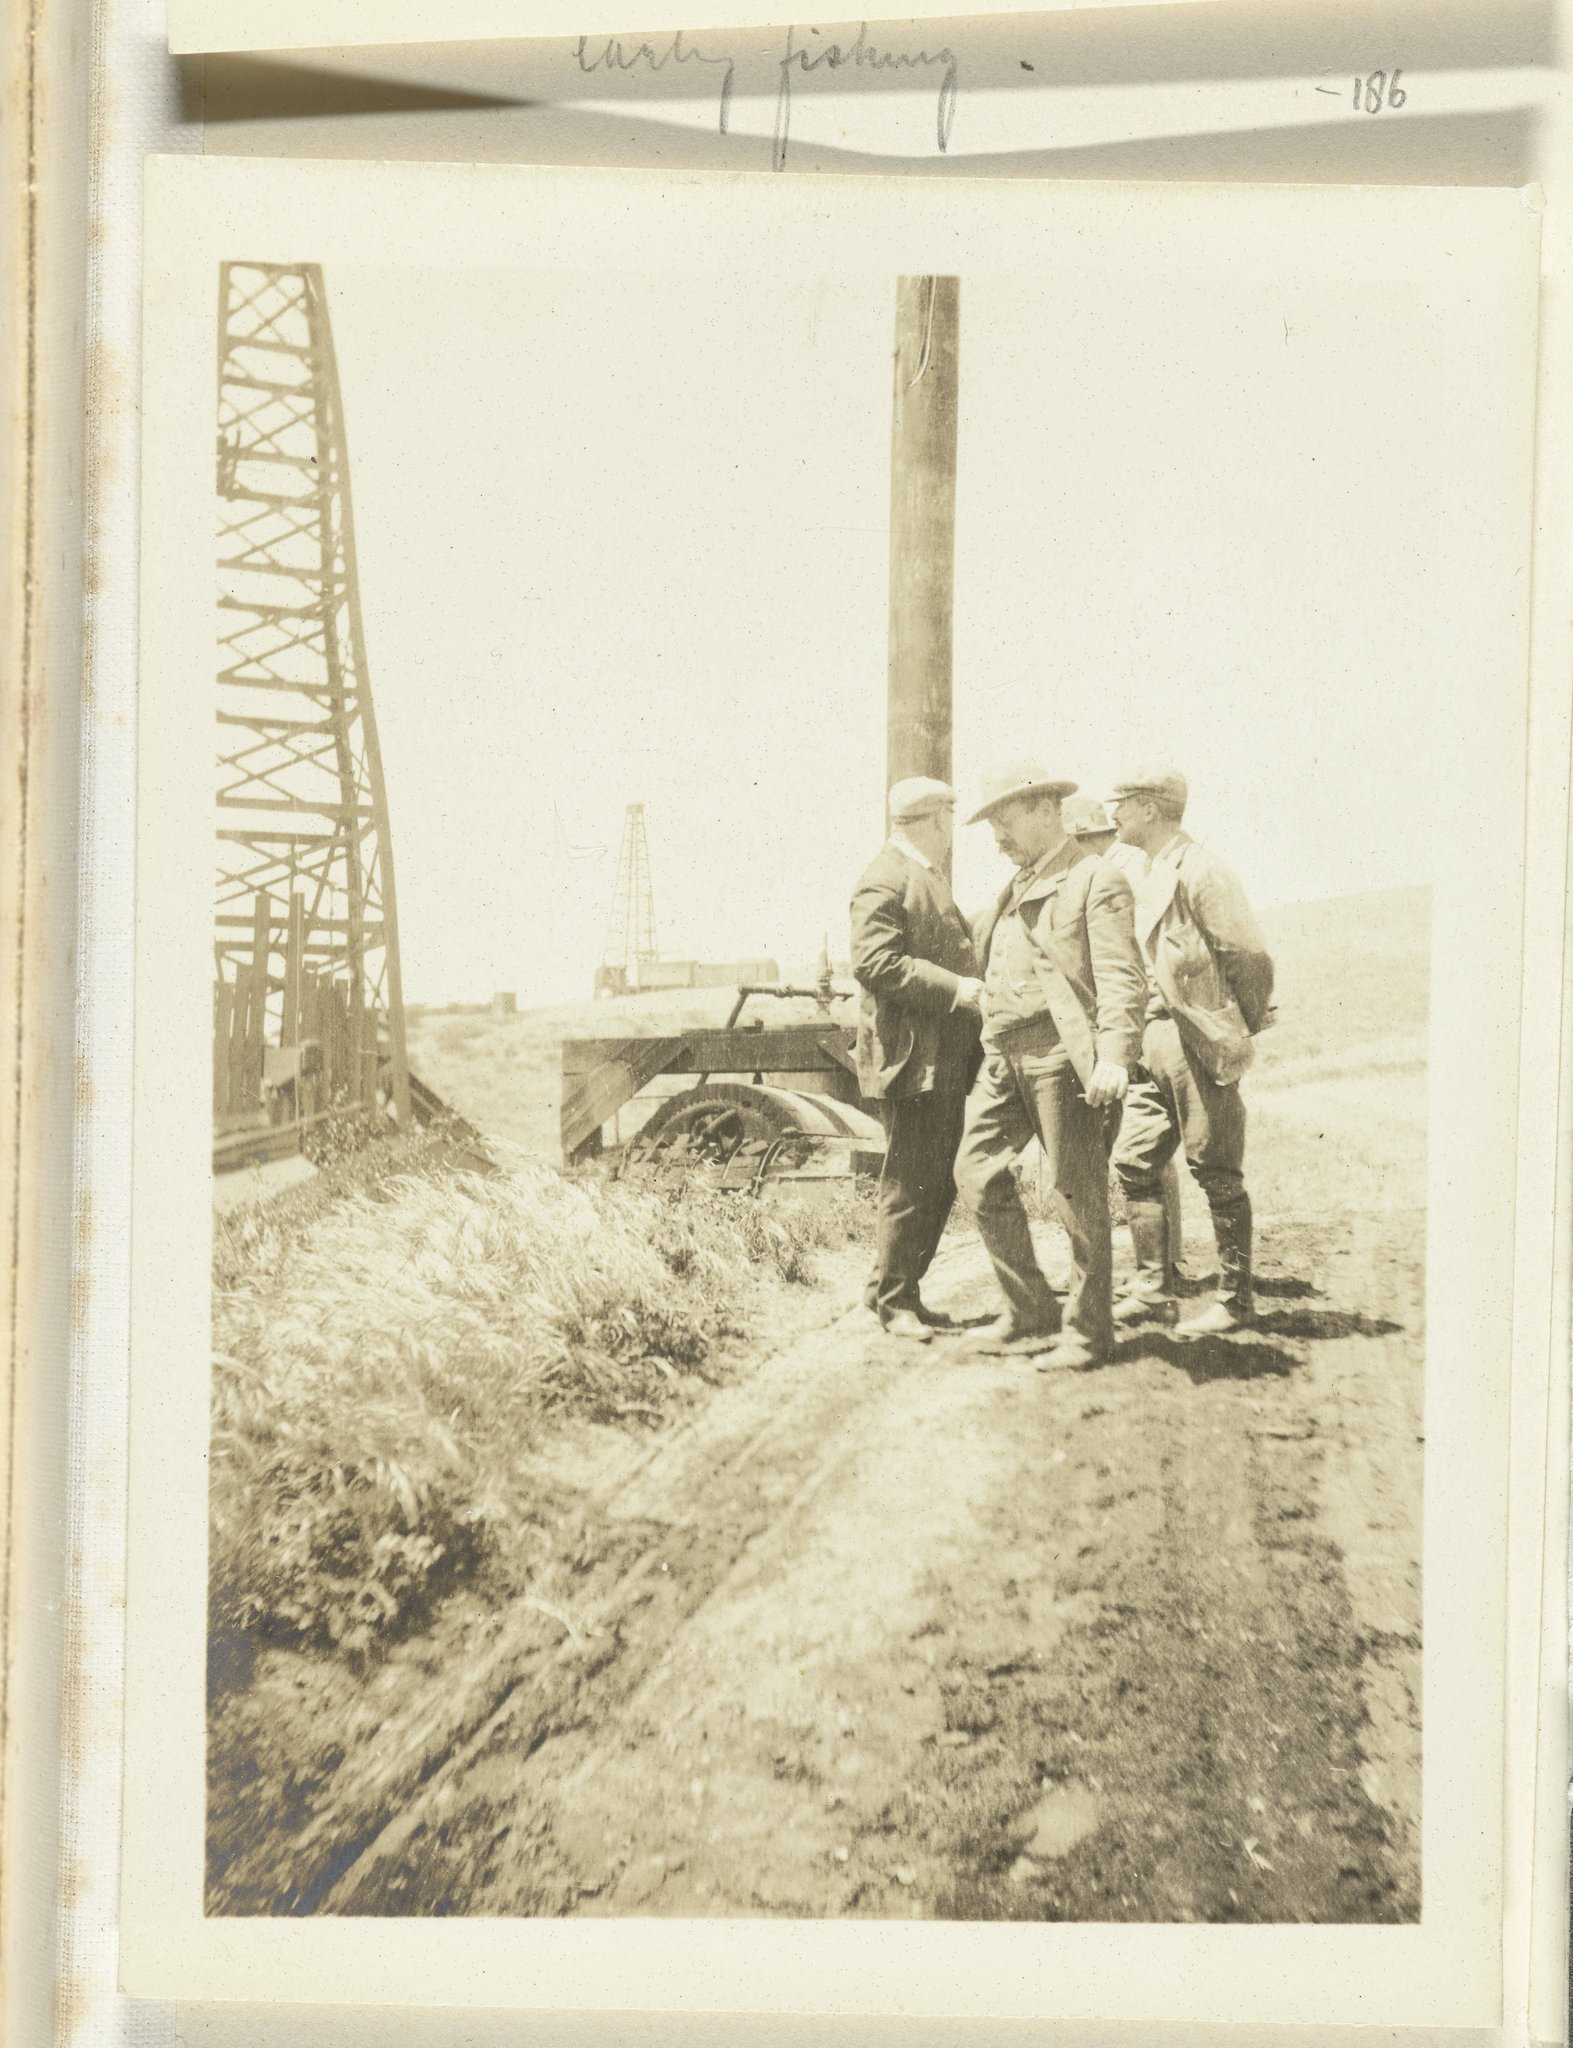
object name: photograph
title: The Oilfields in the Purisima Hills, Southern California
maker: geldolph adriaan kessler (dolph)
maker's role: fotograaf, industrieel, voetballer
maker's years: 1884-1945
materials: cardboard, photographic support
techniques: gelatin silver print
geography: california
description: In 1908 Kessler accompanied the director of Koninklijke Olie (Royal Dutch Petroleum Company, later Shell), Henri Deterding, as secretary on a world tour. He travelled to Canada and the United States via the Dutch East Indies, Singapore, China, and Japan. Dolph’s photo album contains pictures of an oil field in California, as well as San Francisco’s town hall which had collapsed during an earthquake.